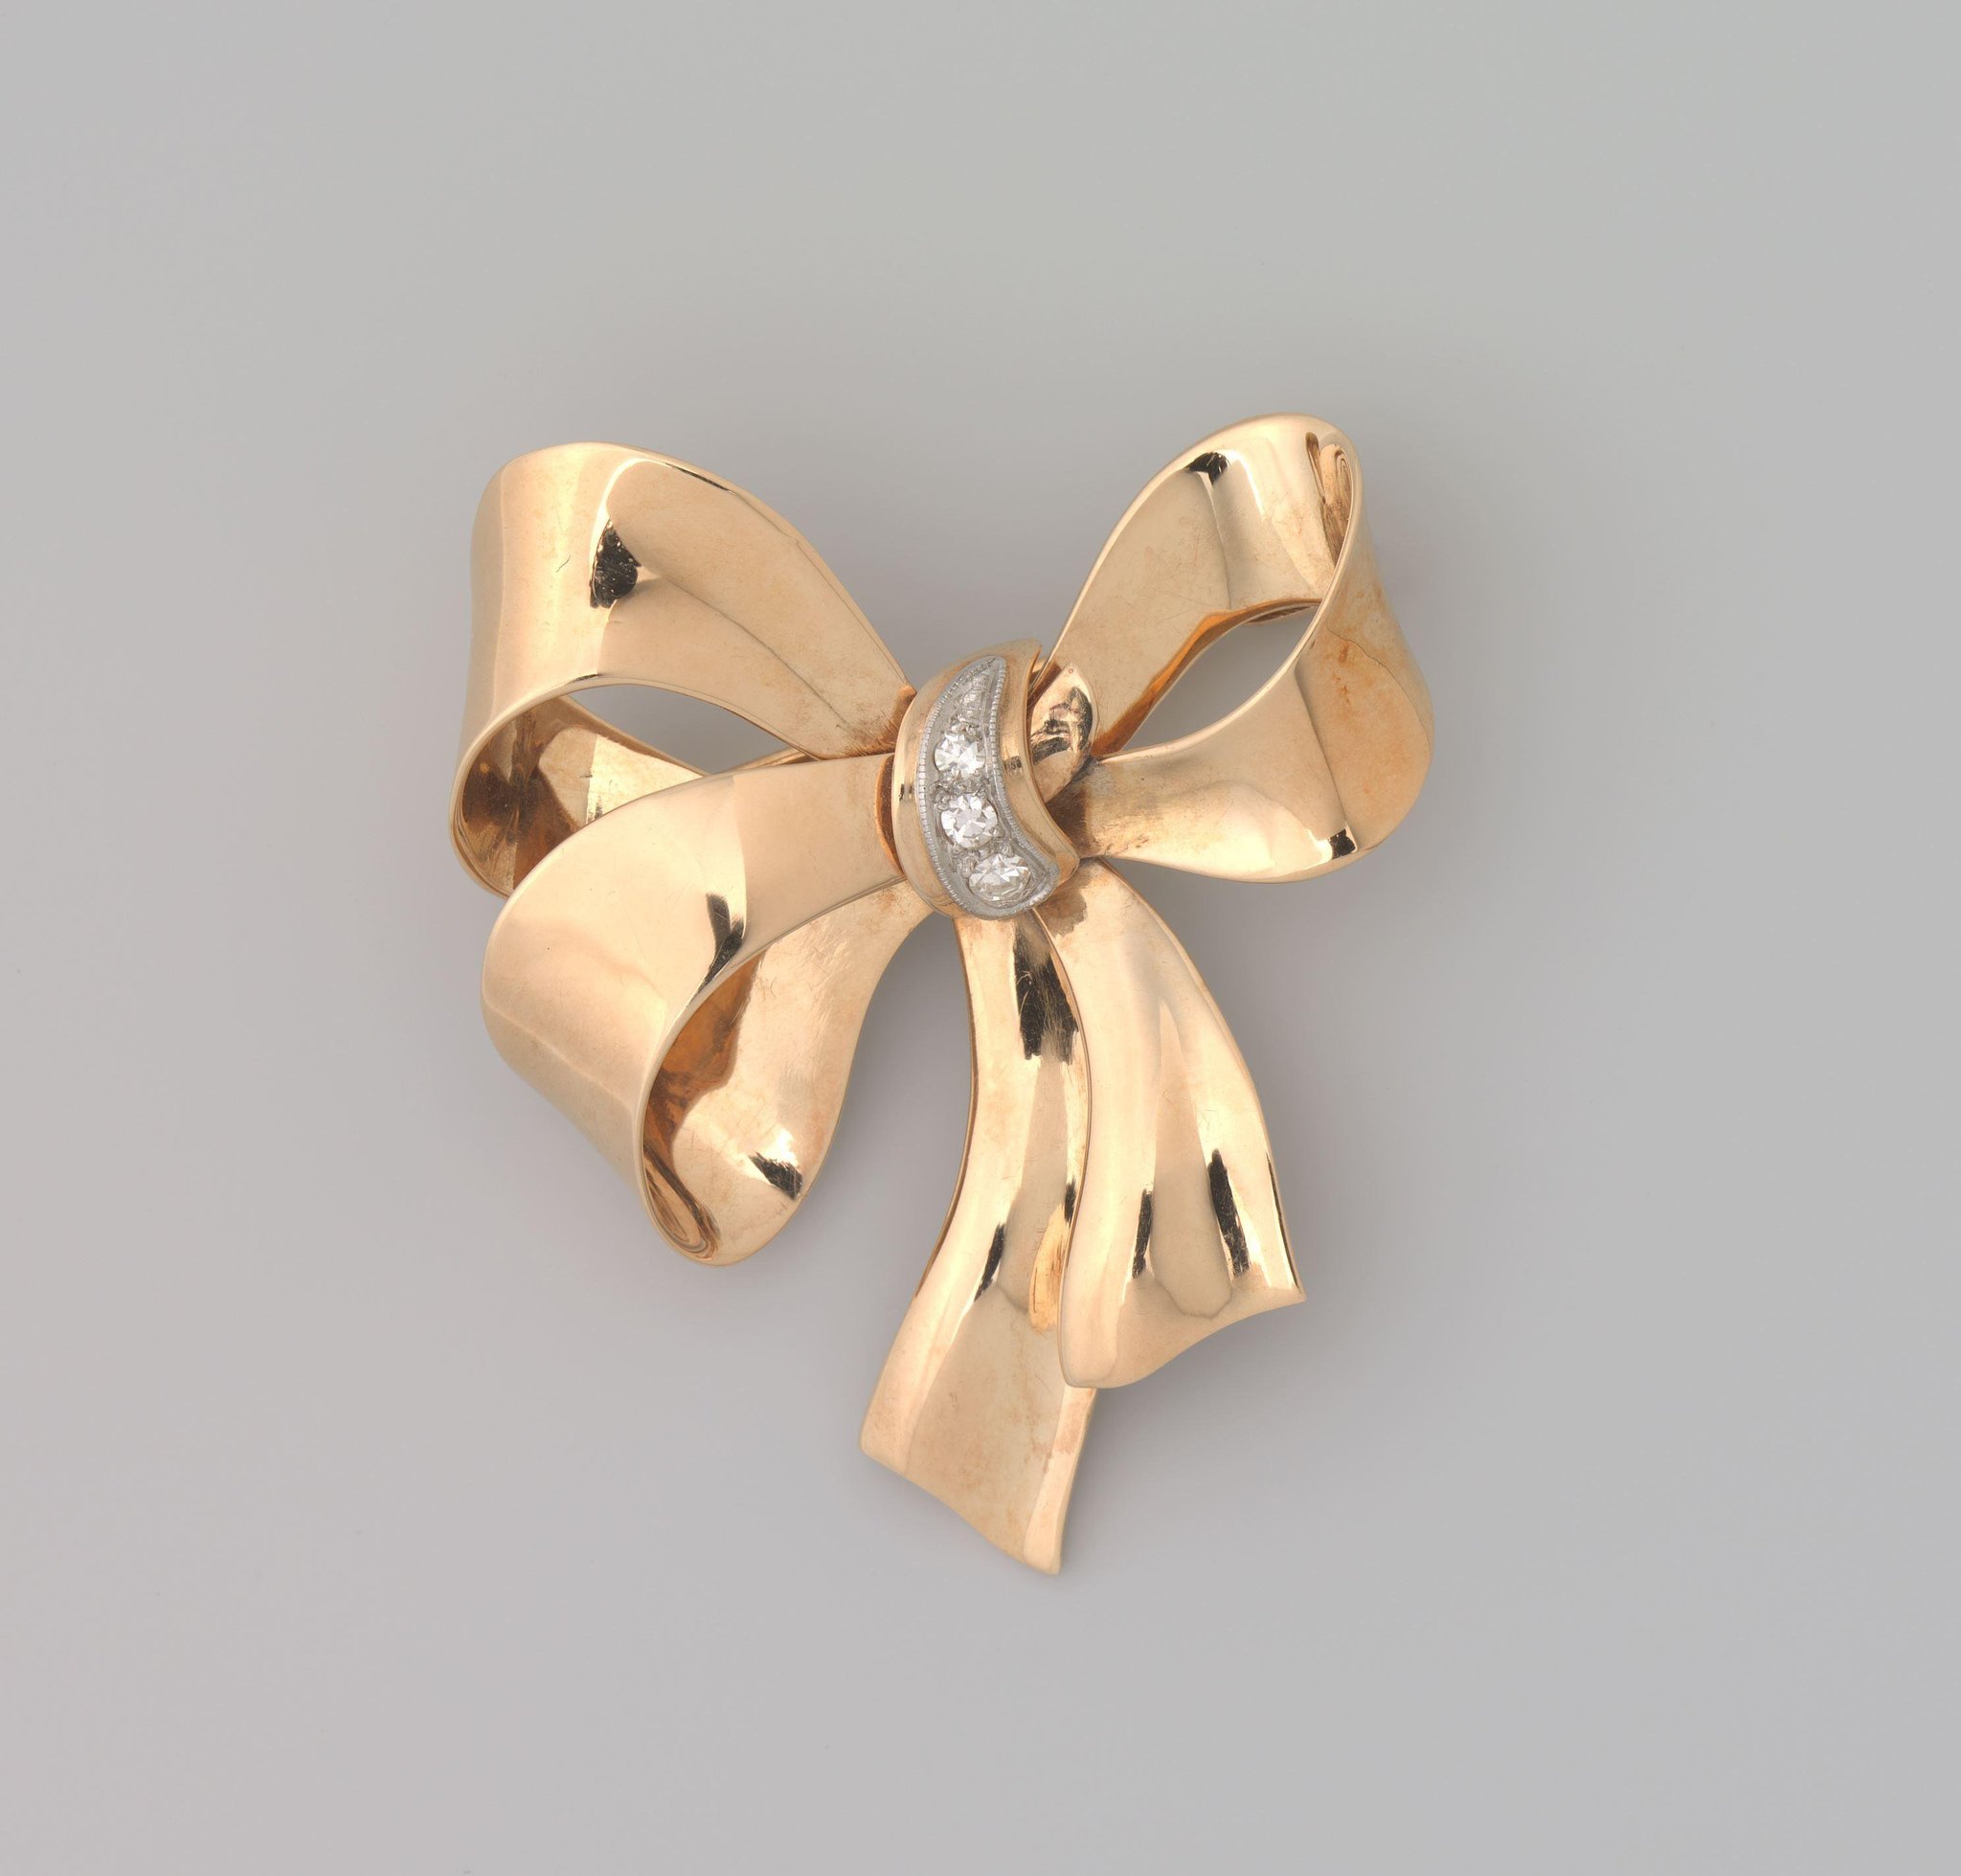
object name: brooch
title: Strikbroche of reversspeld van goud met drie diamanten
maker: Anonymous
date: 1950-1953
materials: diamond, gold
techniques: grinding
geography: the hague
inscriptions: alloy mark: ‘(oud) eikenblad’, maker's mark: ‘V’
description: Strikbroche of reversspeld van goud met diamanten voorzien van een kanonsluiting.